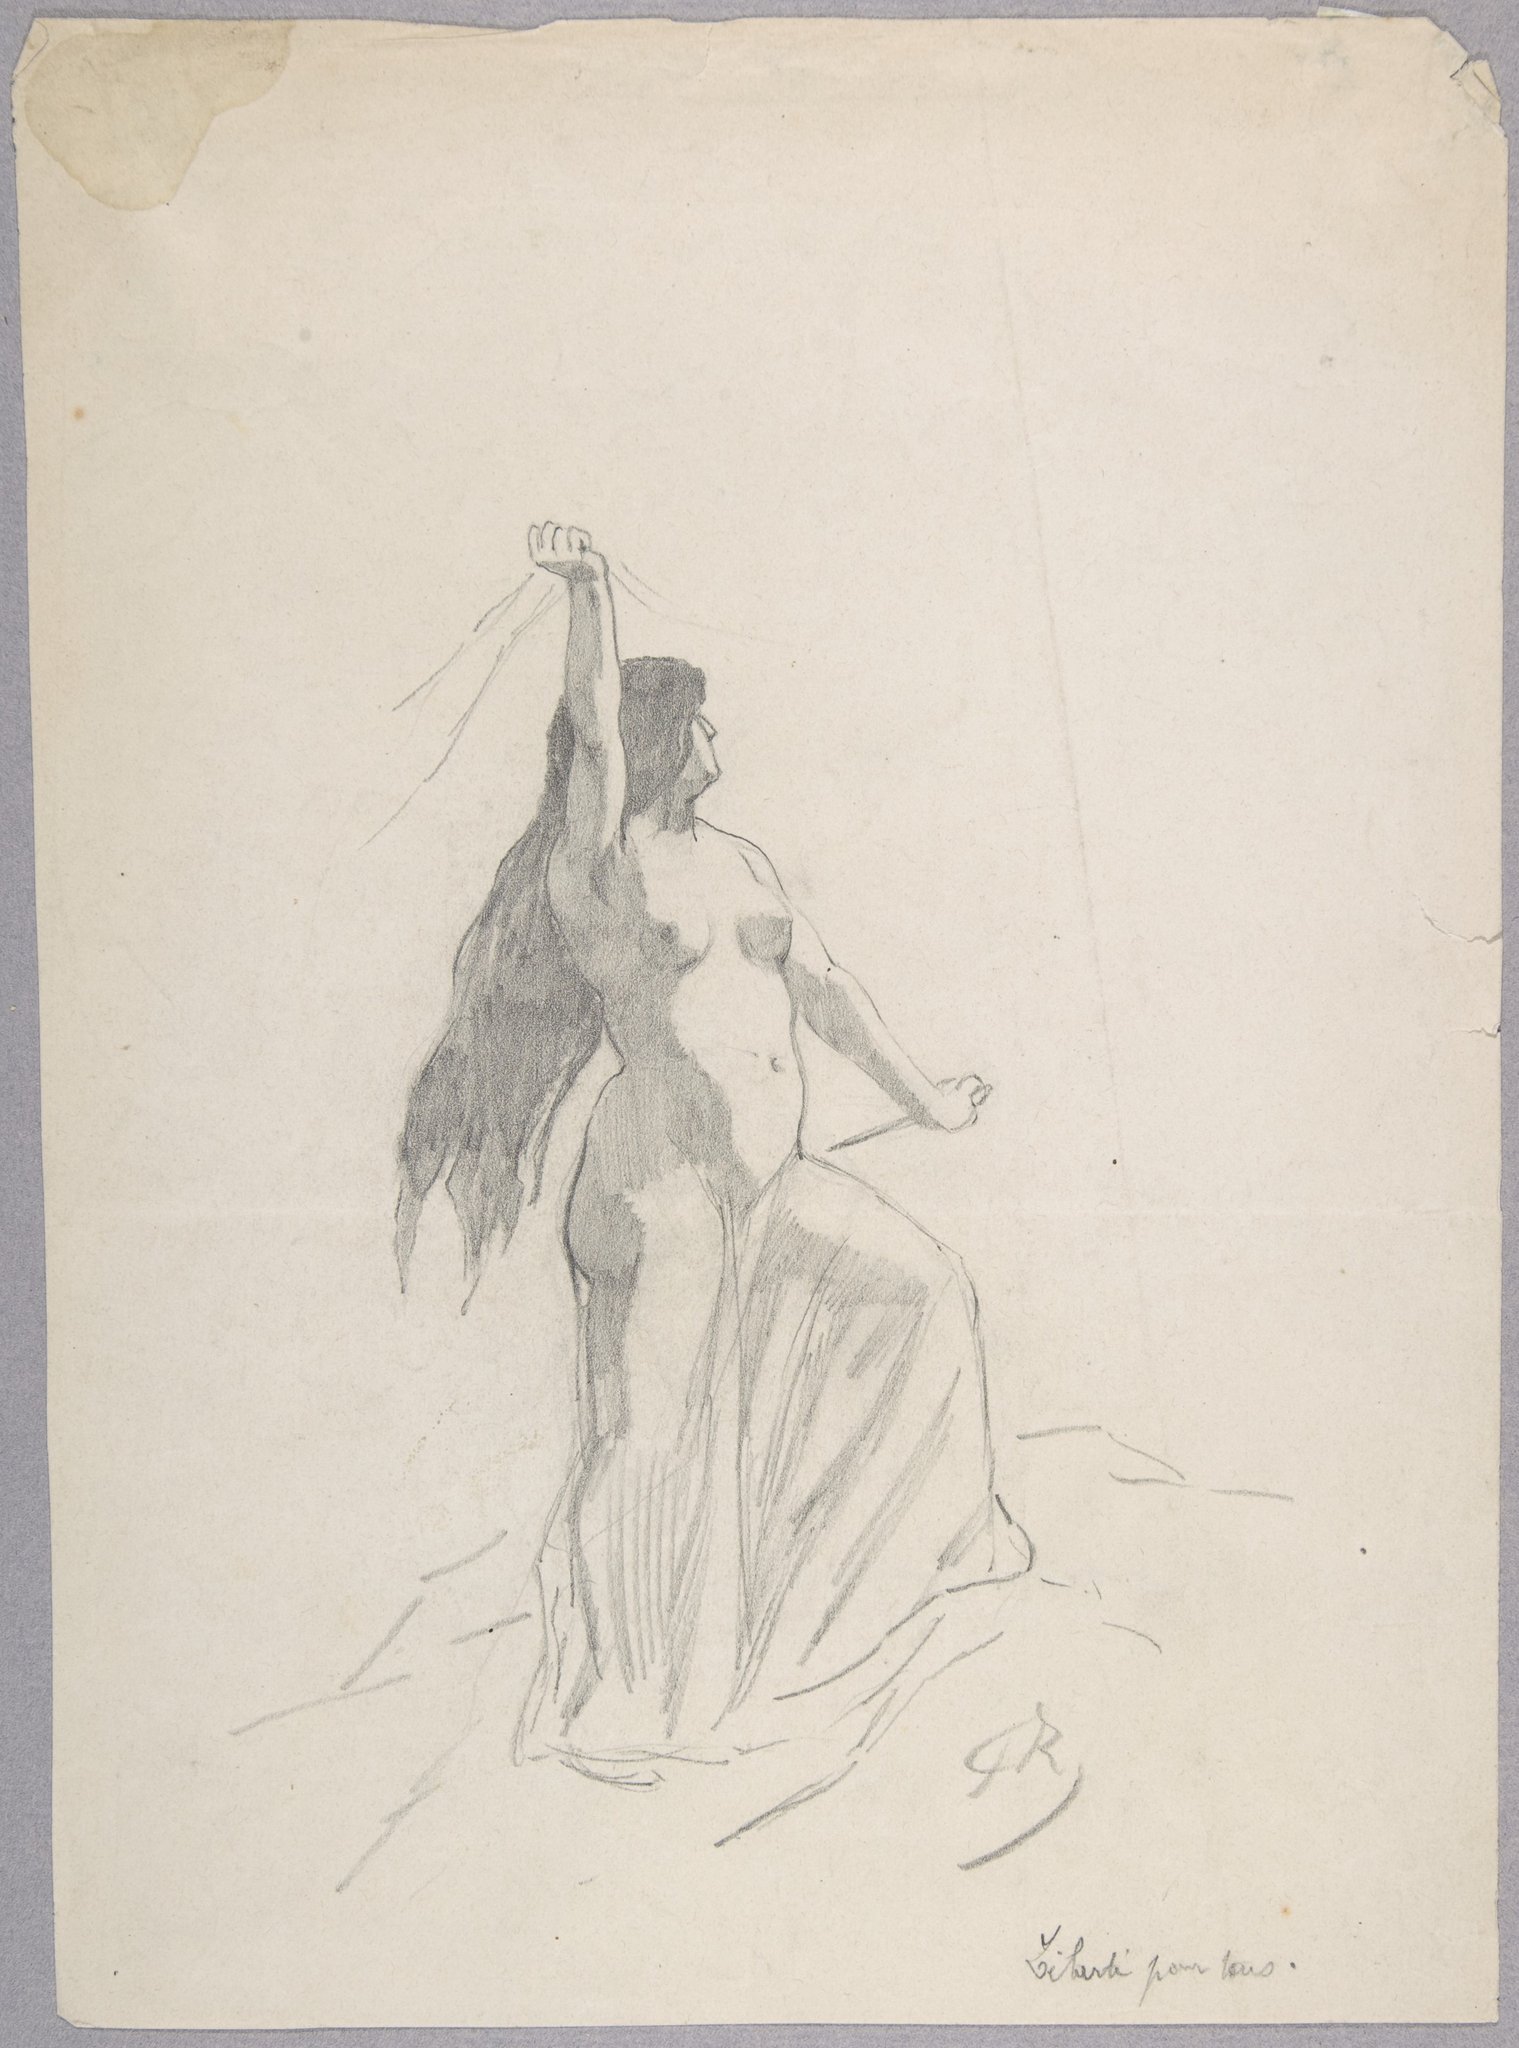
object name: drawing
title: Liberté pour tous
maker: félicien rops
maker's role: artist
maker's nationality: belgian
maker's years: 1833-1898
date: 1833-1898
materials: graphite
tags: female nudes